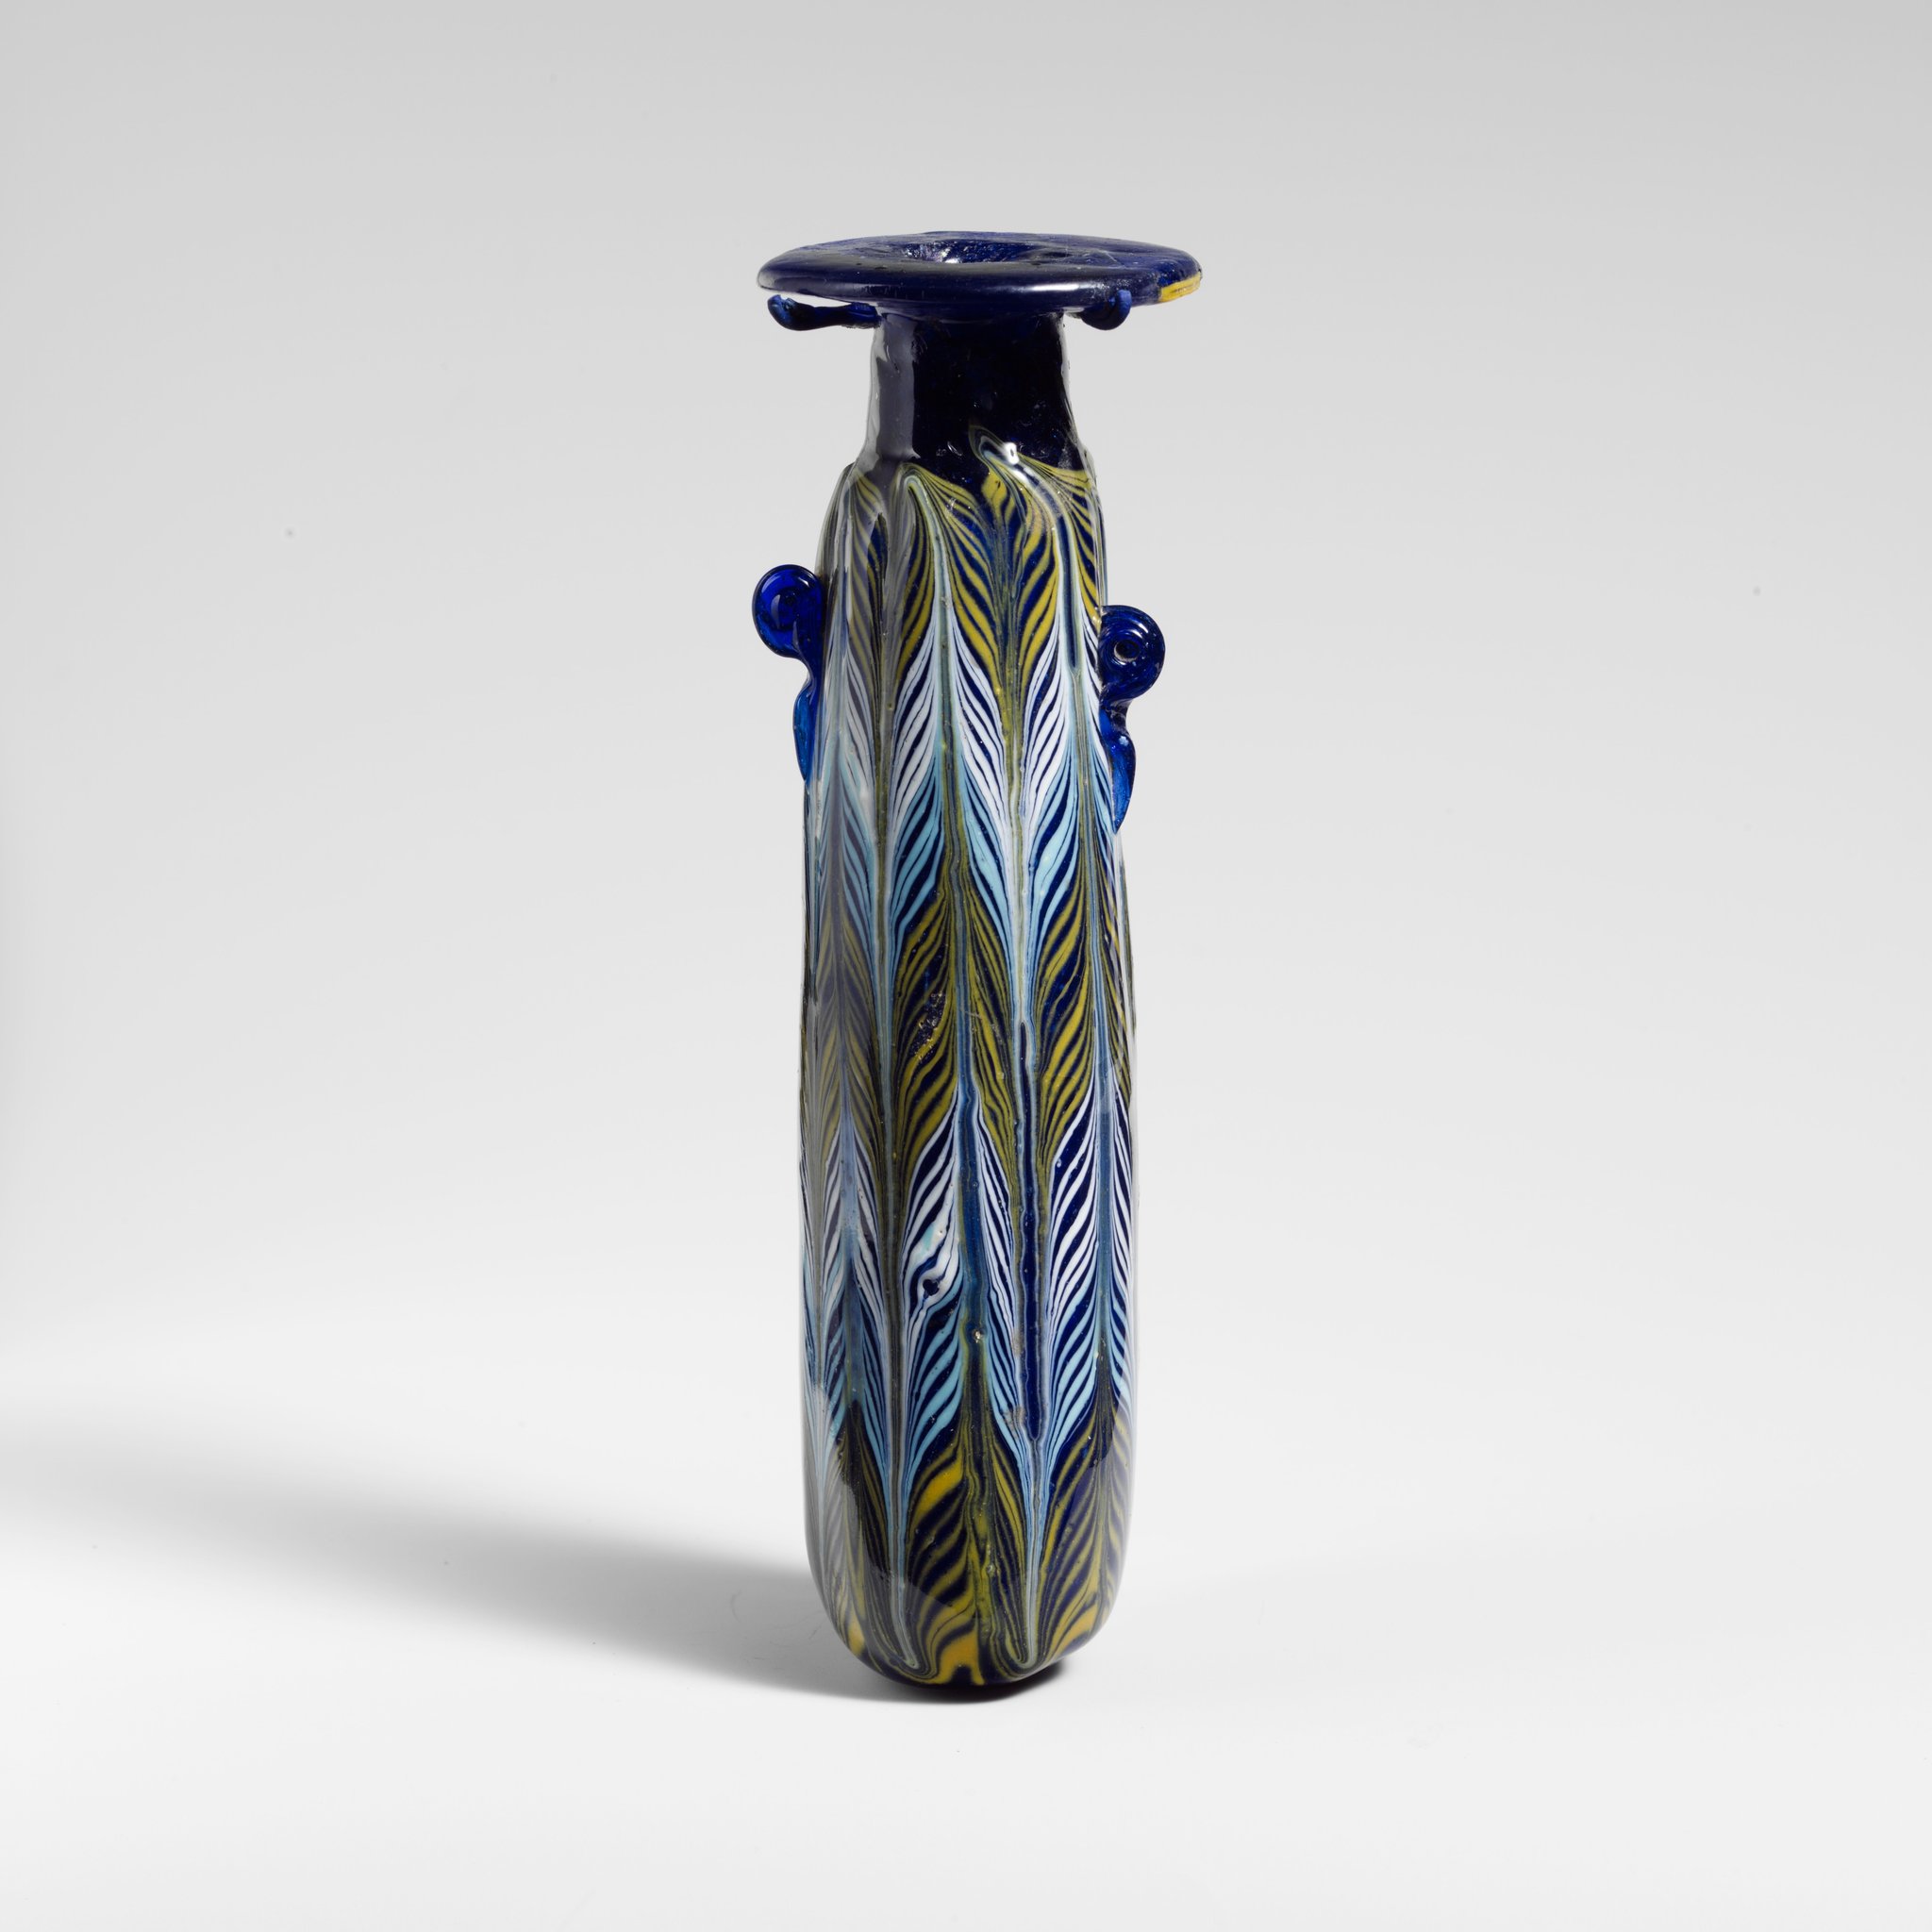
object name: alabastron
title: Glass alabastron (perfume bottle)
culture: eastern mediterranean or italian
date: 334-268 BCE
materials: glass